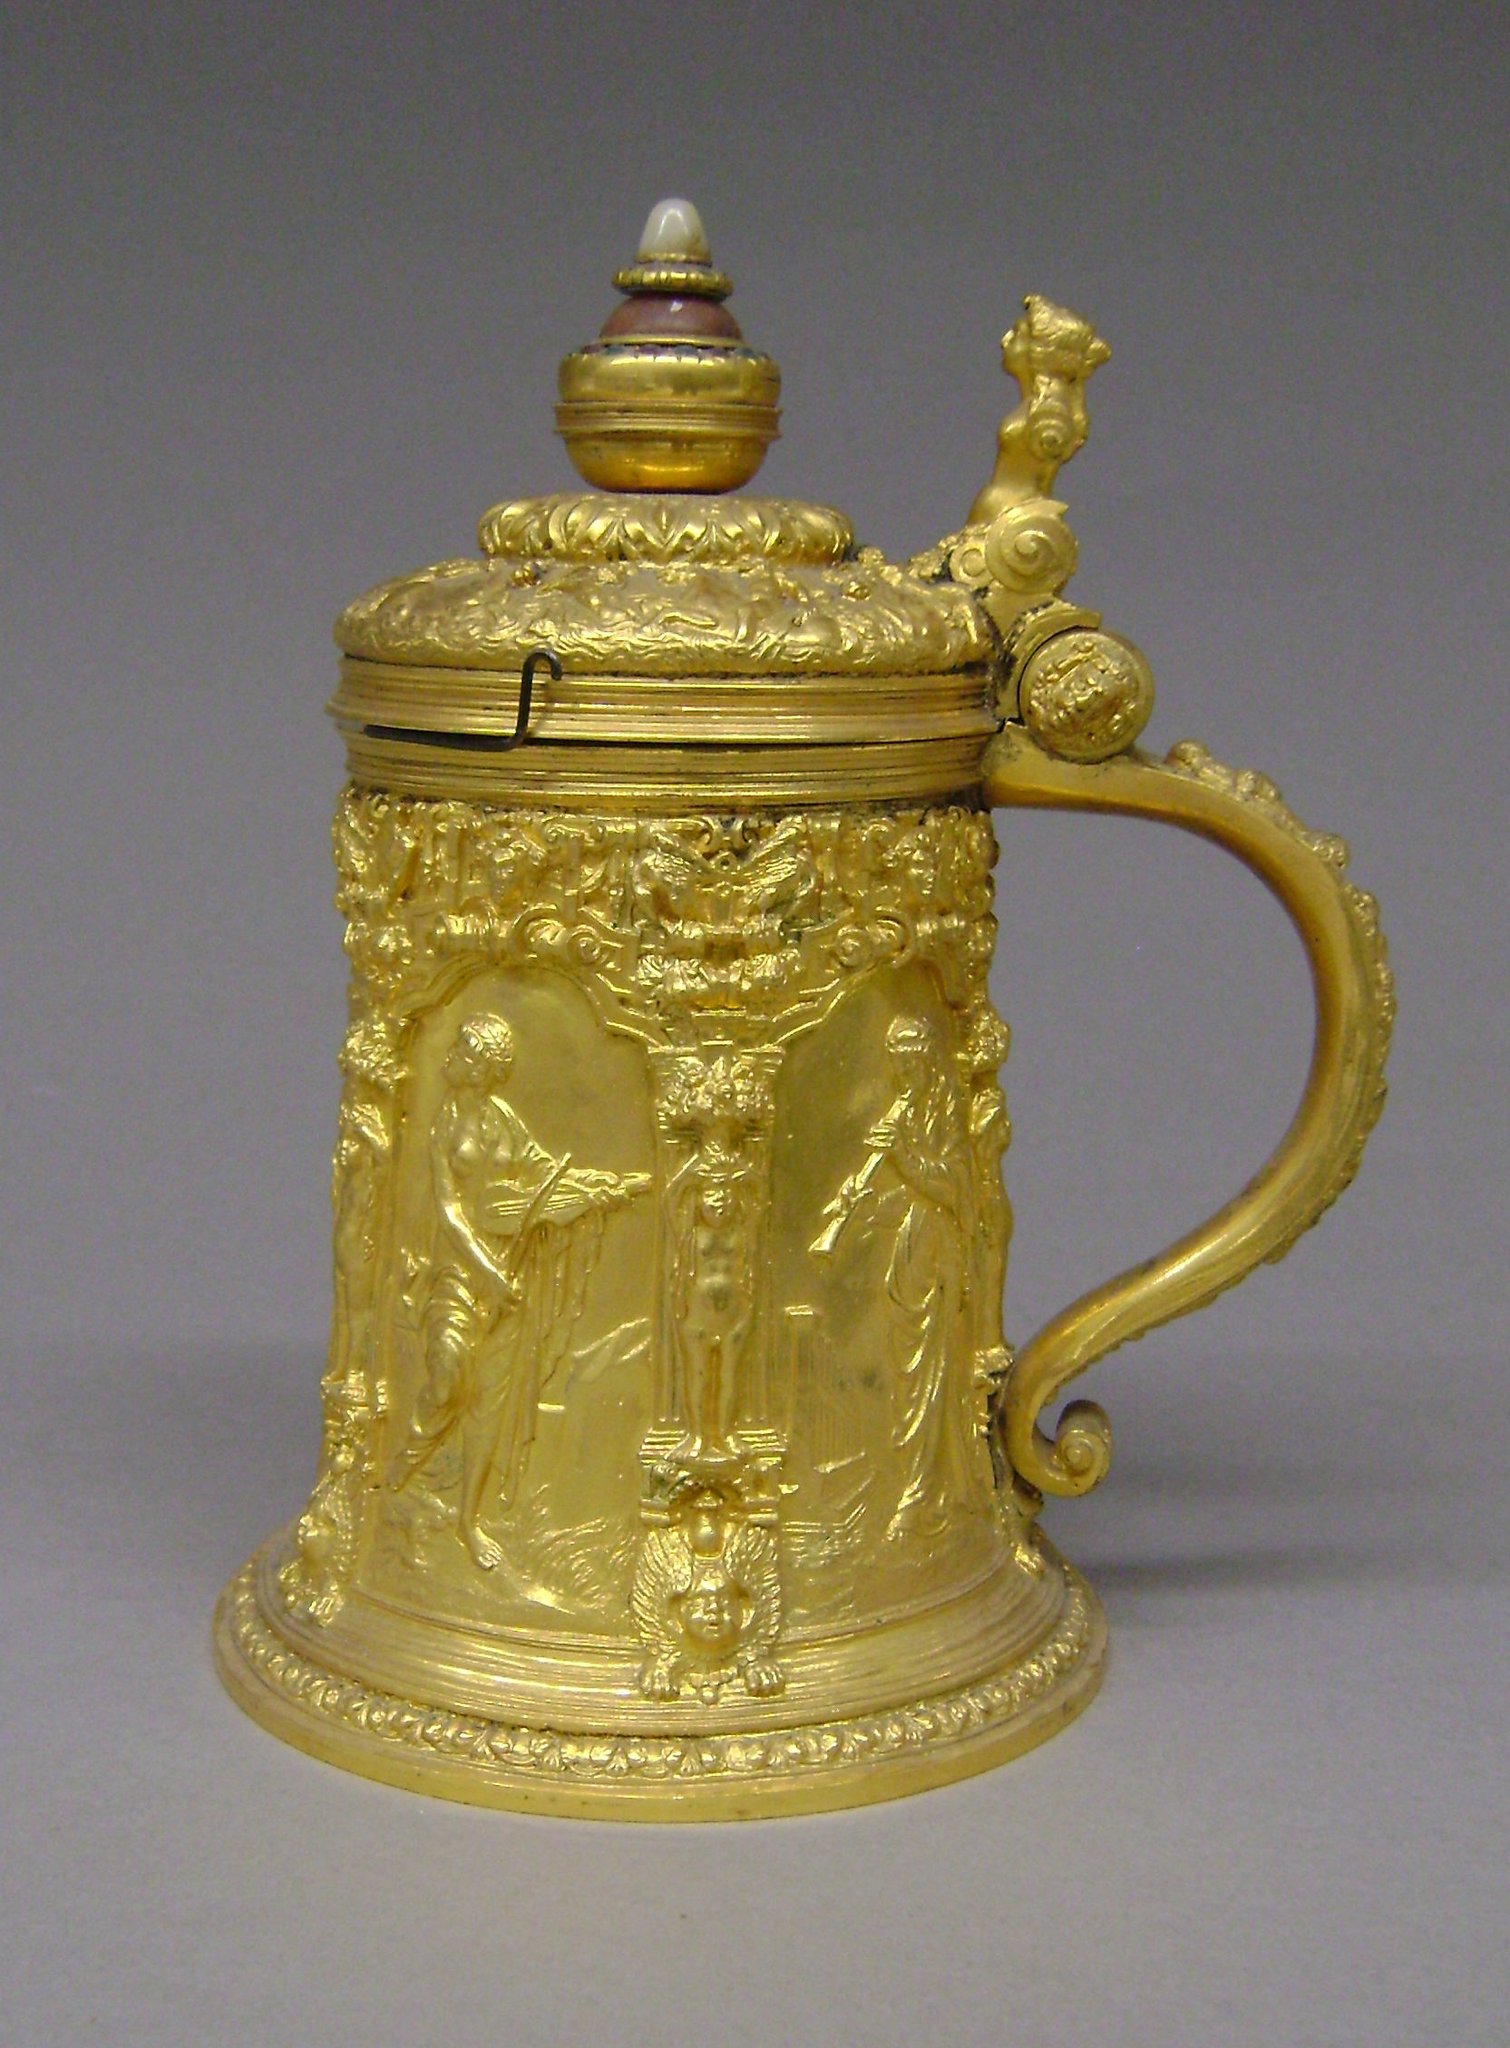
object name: tankard with cover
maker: elkington & co.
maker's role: manufacturer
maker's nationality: british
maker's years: 1829-1963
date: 1801-1900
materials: metal, silver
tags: musical instruments,women